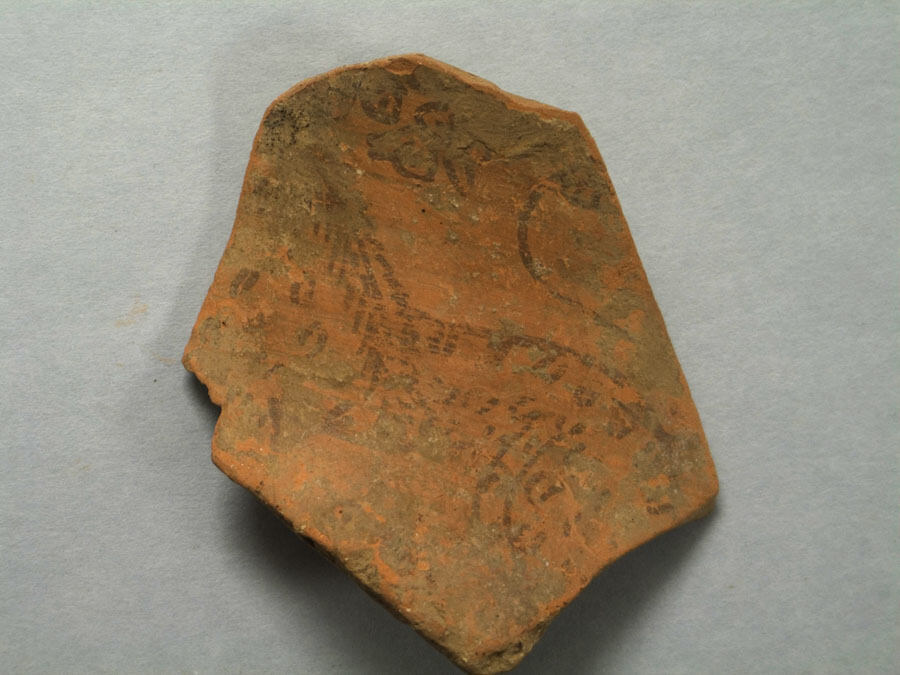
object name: shard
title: Shard: Carnivore's Torso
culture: pakistani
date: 301-500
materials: terracotta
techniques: painting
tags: gandhara